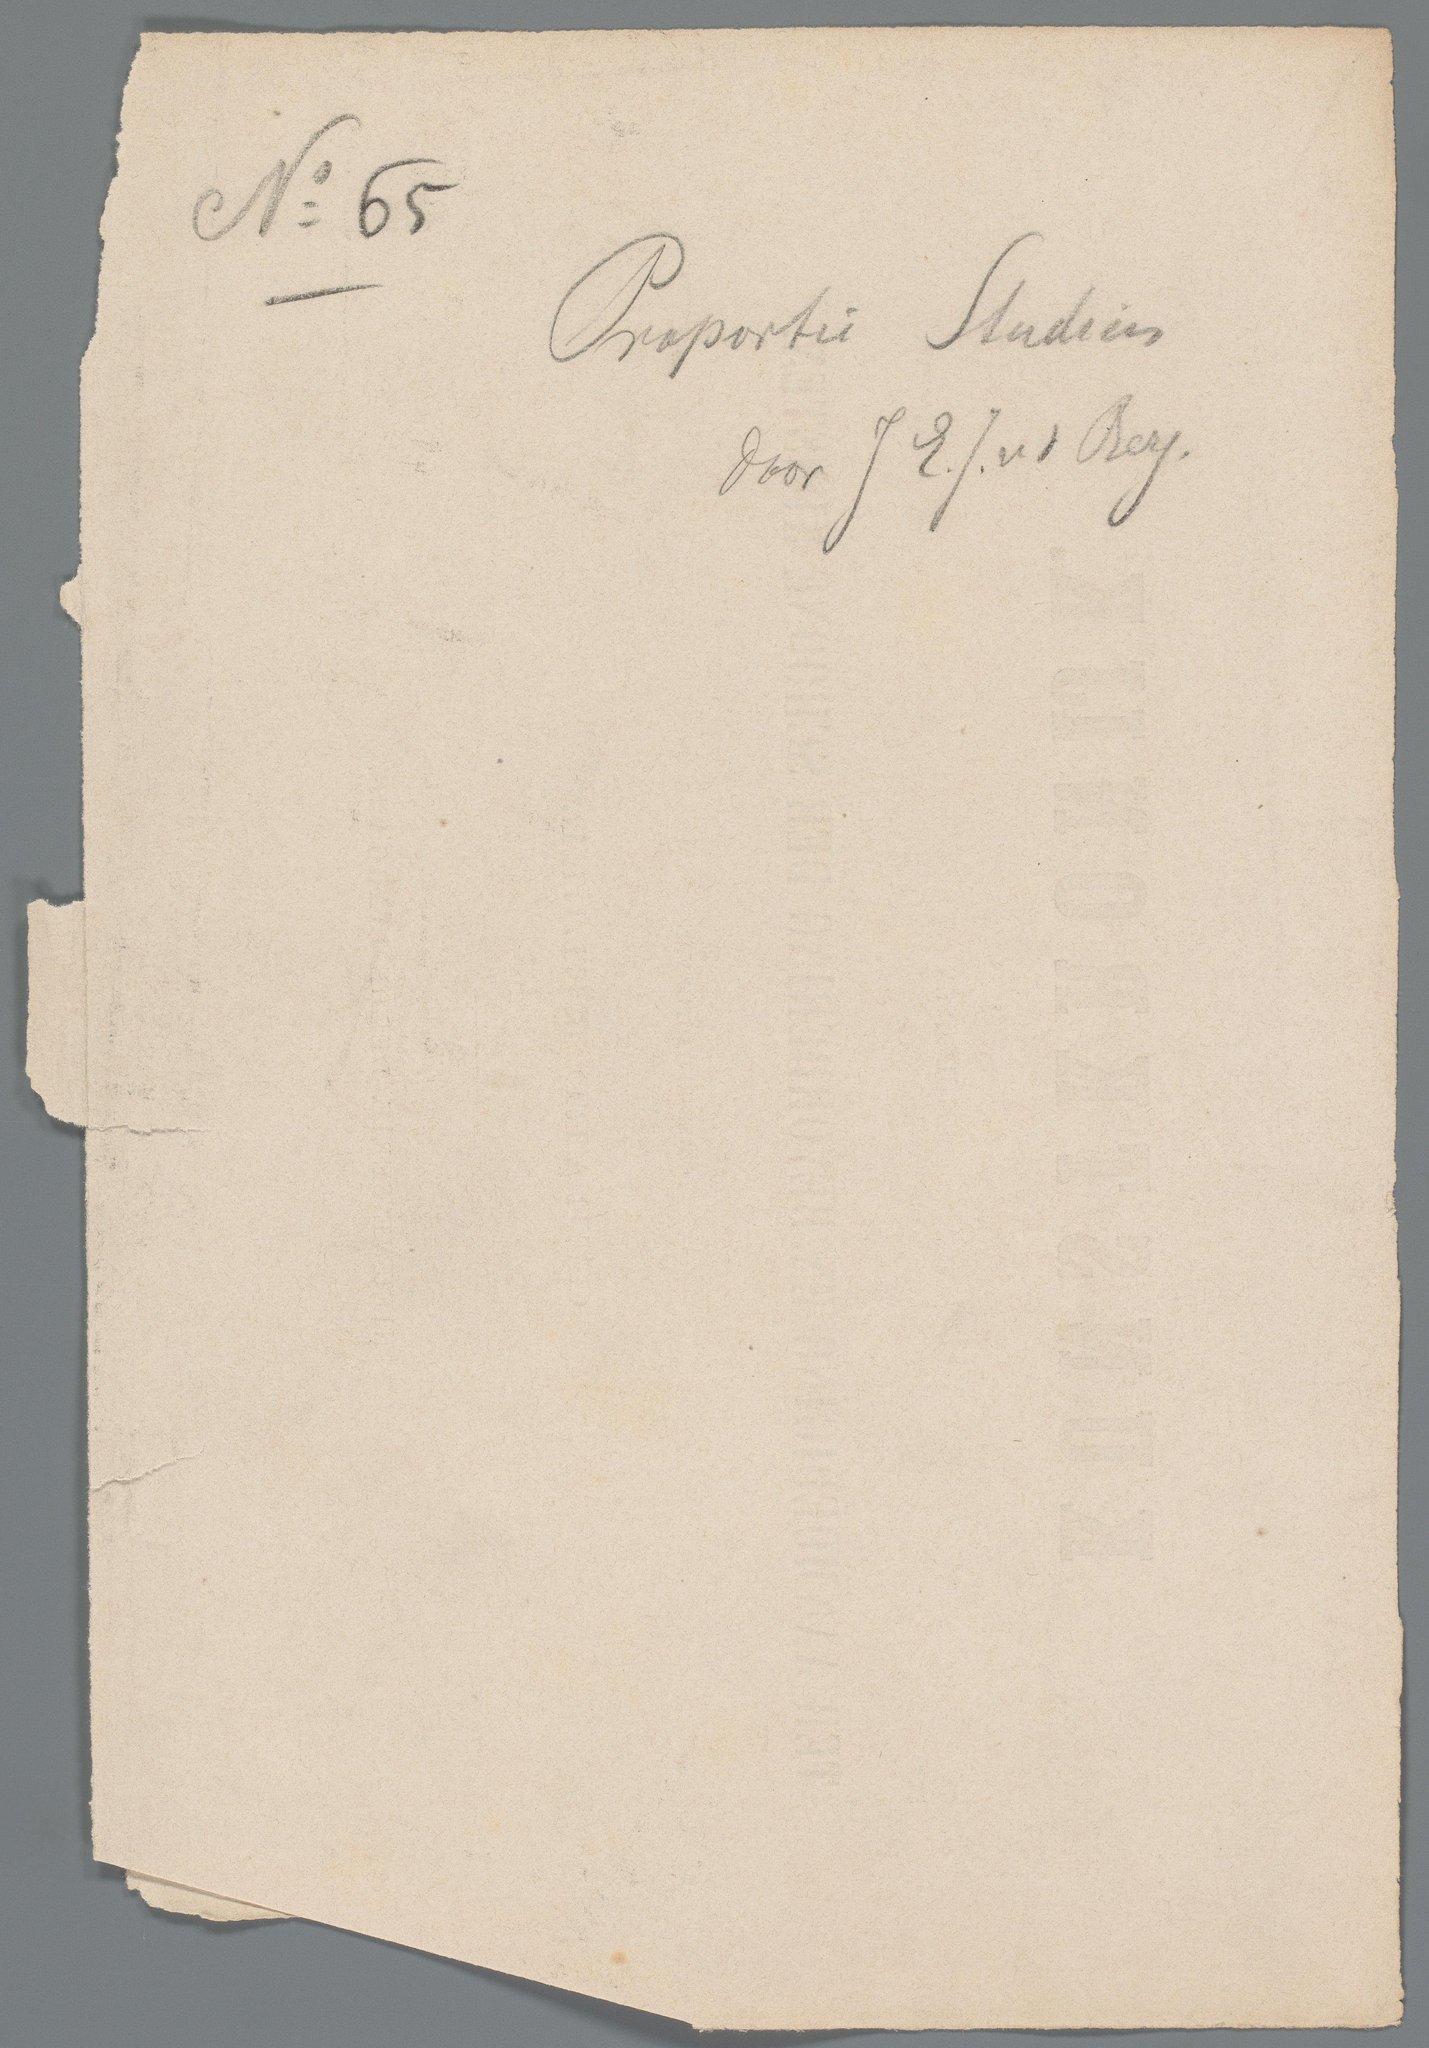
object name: document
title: Proportie studies door J.E.J. vd Berg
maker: jacobus everhardus josephus van den berg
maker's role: draughtsman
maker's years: 1802-1861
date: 1812-1861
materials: paper, pencil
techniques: letterpress printing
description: Notitie op de achterkant van het titelblad van de derde jaargang van de 'Kunstkronijk' (1846).